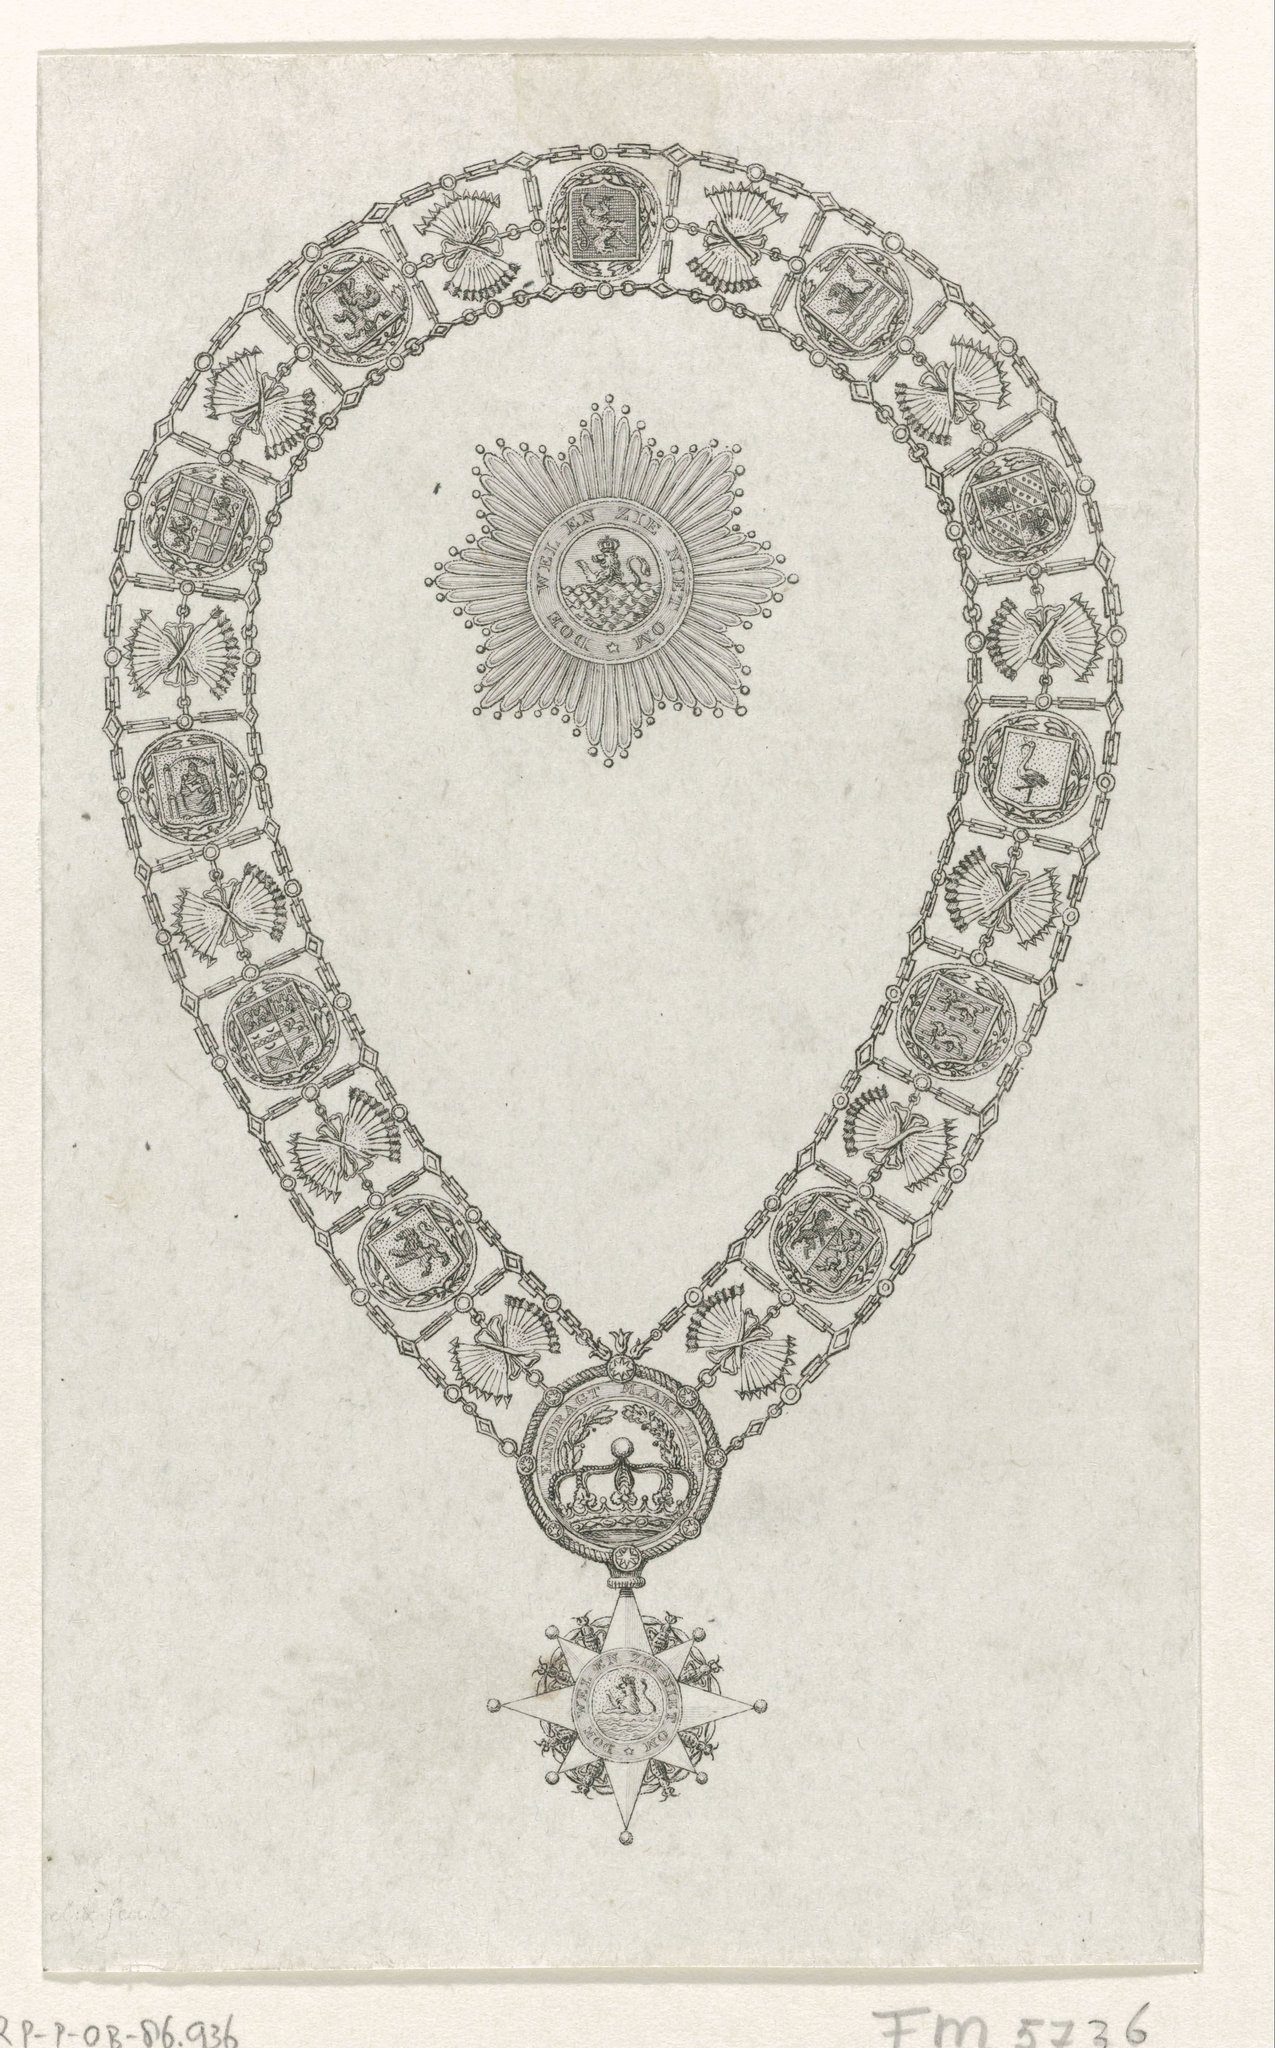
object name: print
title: Ordeketen met het grootkruis van de Koninklijke Orde van Holland, 1807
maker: Anonymous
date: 1807-1810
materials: paper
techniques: engraving, etching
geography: netherlands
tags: louis napoleon (king of holland), knighthood order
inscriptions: collector's mark: Lugt 2228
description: Het Grote Keten met het kruis van de Koninklijke Orde van Holland, later genoemd Orde van de Unie. Onderscheiding ingesteld door koning Lodewijk Napoleon, voor het eerst in 1806. Deze variant van het versiersel met een zwemmende of uitkomende leeuw dateert van 14 februari 1807.